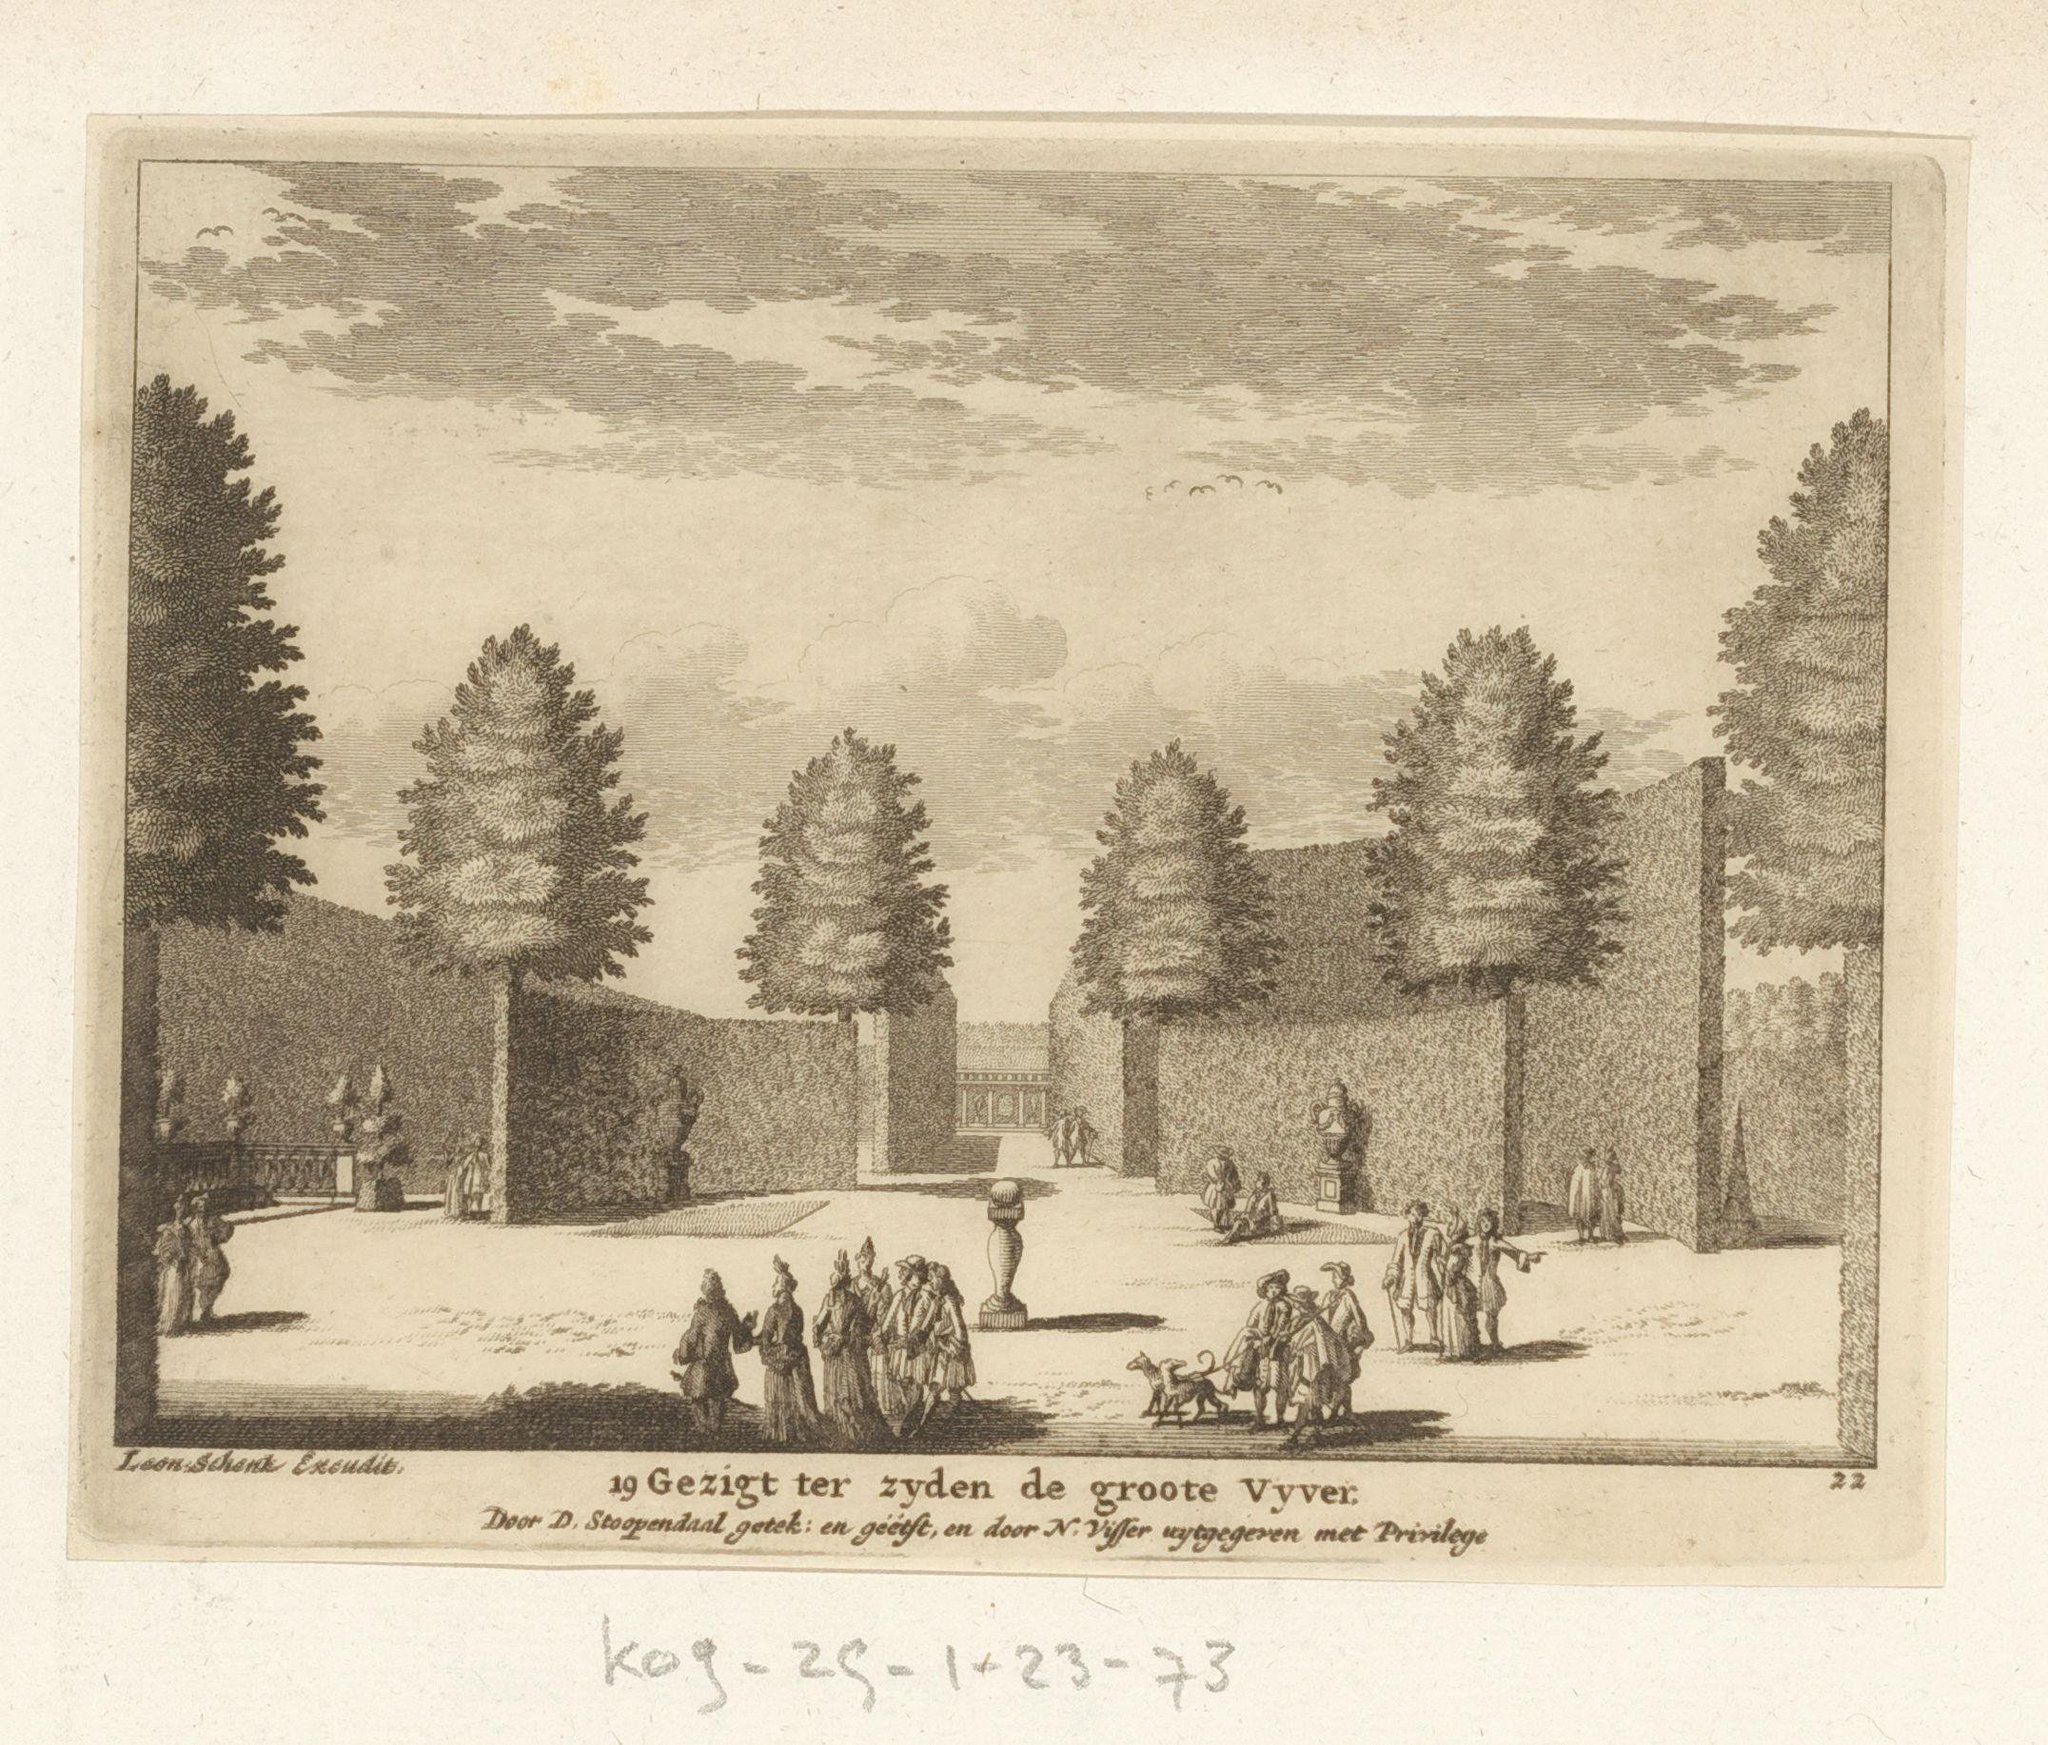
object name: print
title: Verscheyde schoone en vermaakelyke gezigten, in de Hofstede van Clingendaal gelegen by 's Gravenhage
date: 1706-1767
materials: paper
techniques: engraving, etching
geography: amsterdam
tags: french or architectonic garden; formal garden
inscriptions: stamp, stamp, collector's mark: Lugt 1641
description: Gezicht op de tuinen bij Huis Clingendael te Den Haag. Op een plein omgeven door hagen wandelen figuren. Links de steiger met balustrade bij de grote vijver. Onderwerpsrubrieken binnen de Atlas Zeden en Gewoonten: Zeden en Gewoonten in Engeren Zin, De Woning. Kastelen en buitenplaatsen. Holland.